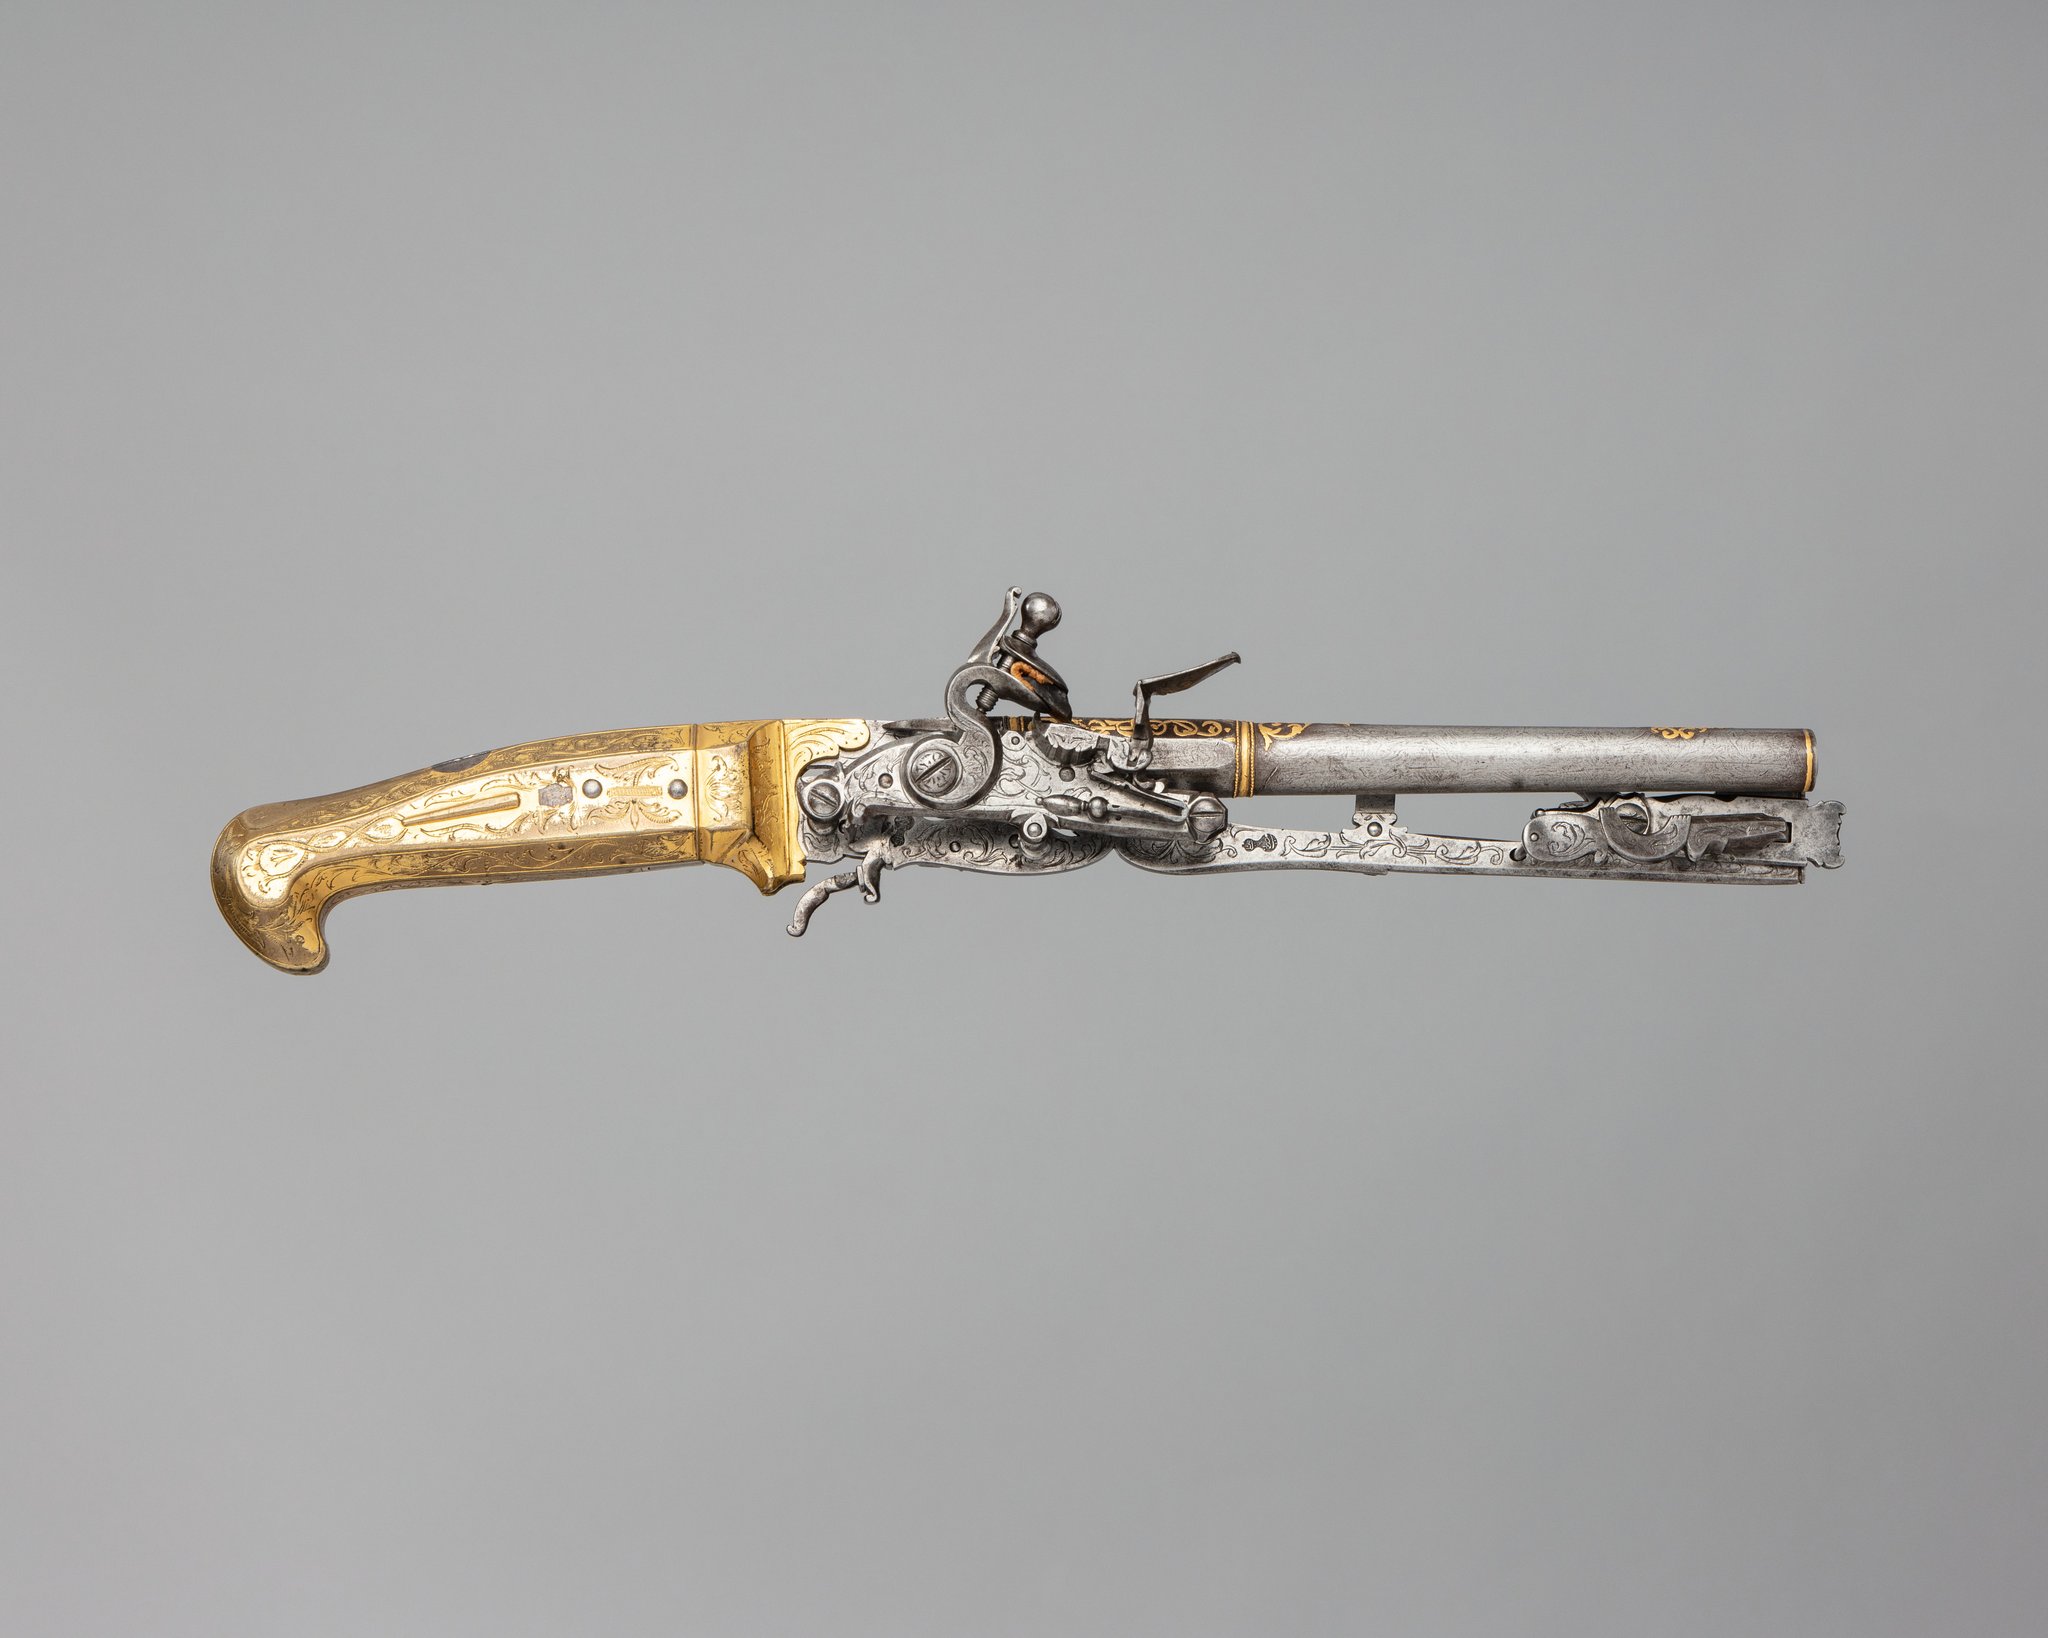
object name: combination flintlock pistol and knife carrier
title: Combination Flintlock and Knife Carrier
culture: turkish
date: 1801-1900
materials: gold, steel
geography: turkey